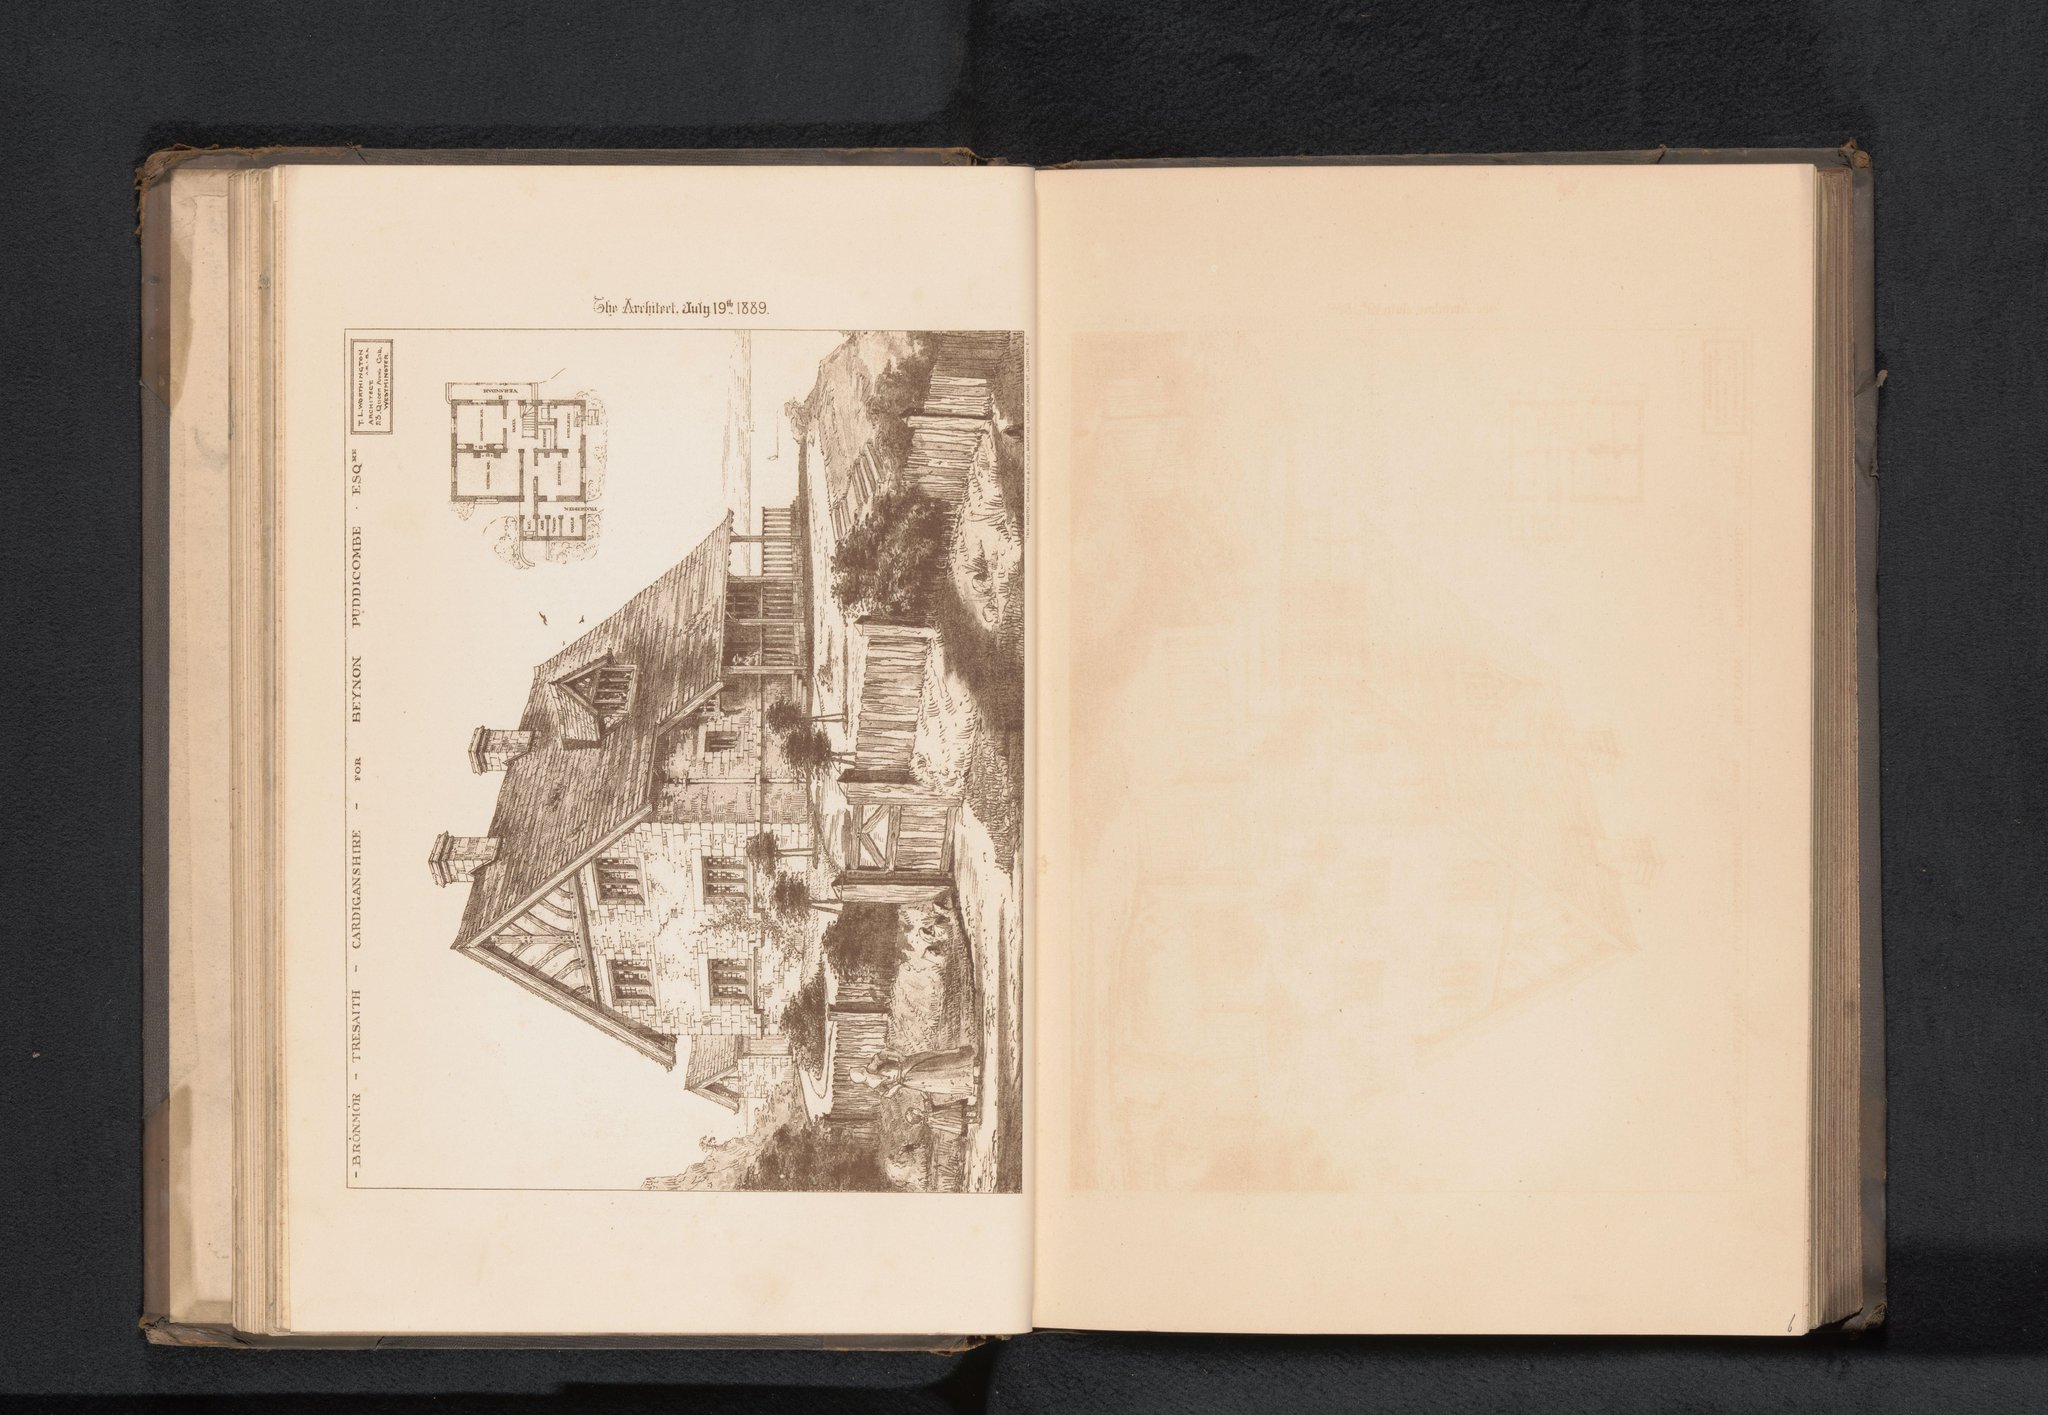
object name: photomechanical print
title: Reproductie van een ontwerp van een huis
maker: Anonymous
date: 1884-1889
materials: paper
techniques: photolithography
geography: london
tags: designing, sketching ~ architect, rural housing, e.g. country-house, villa, cottage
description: Prent op tweede ongenummerde pagina na pagina 34.